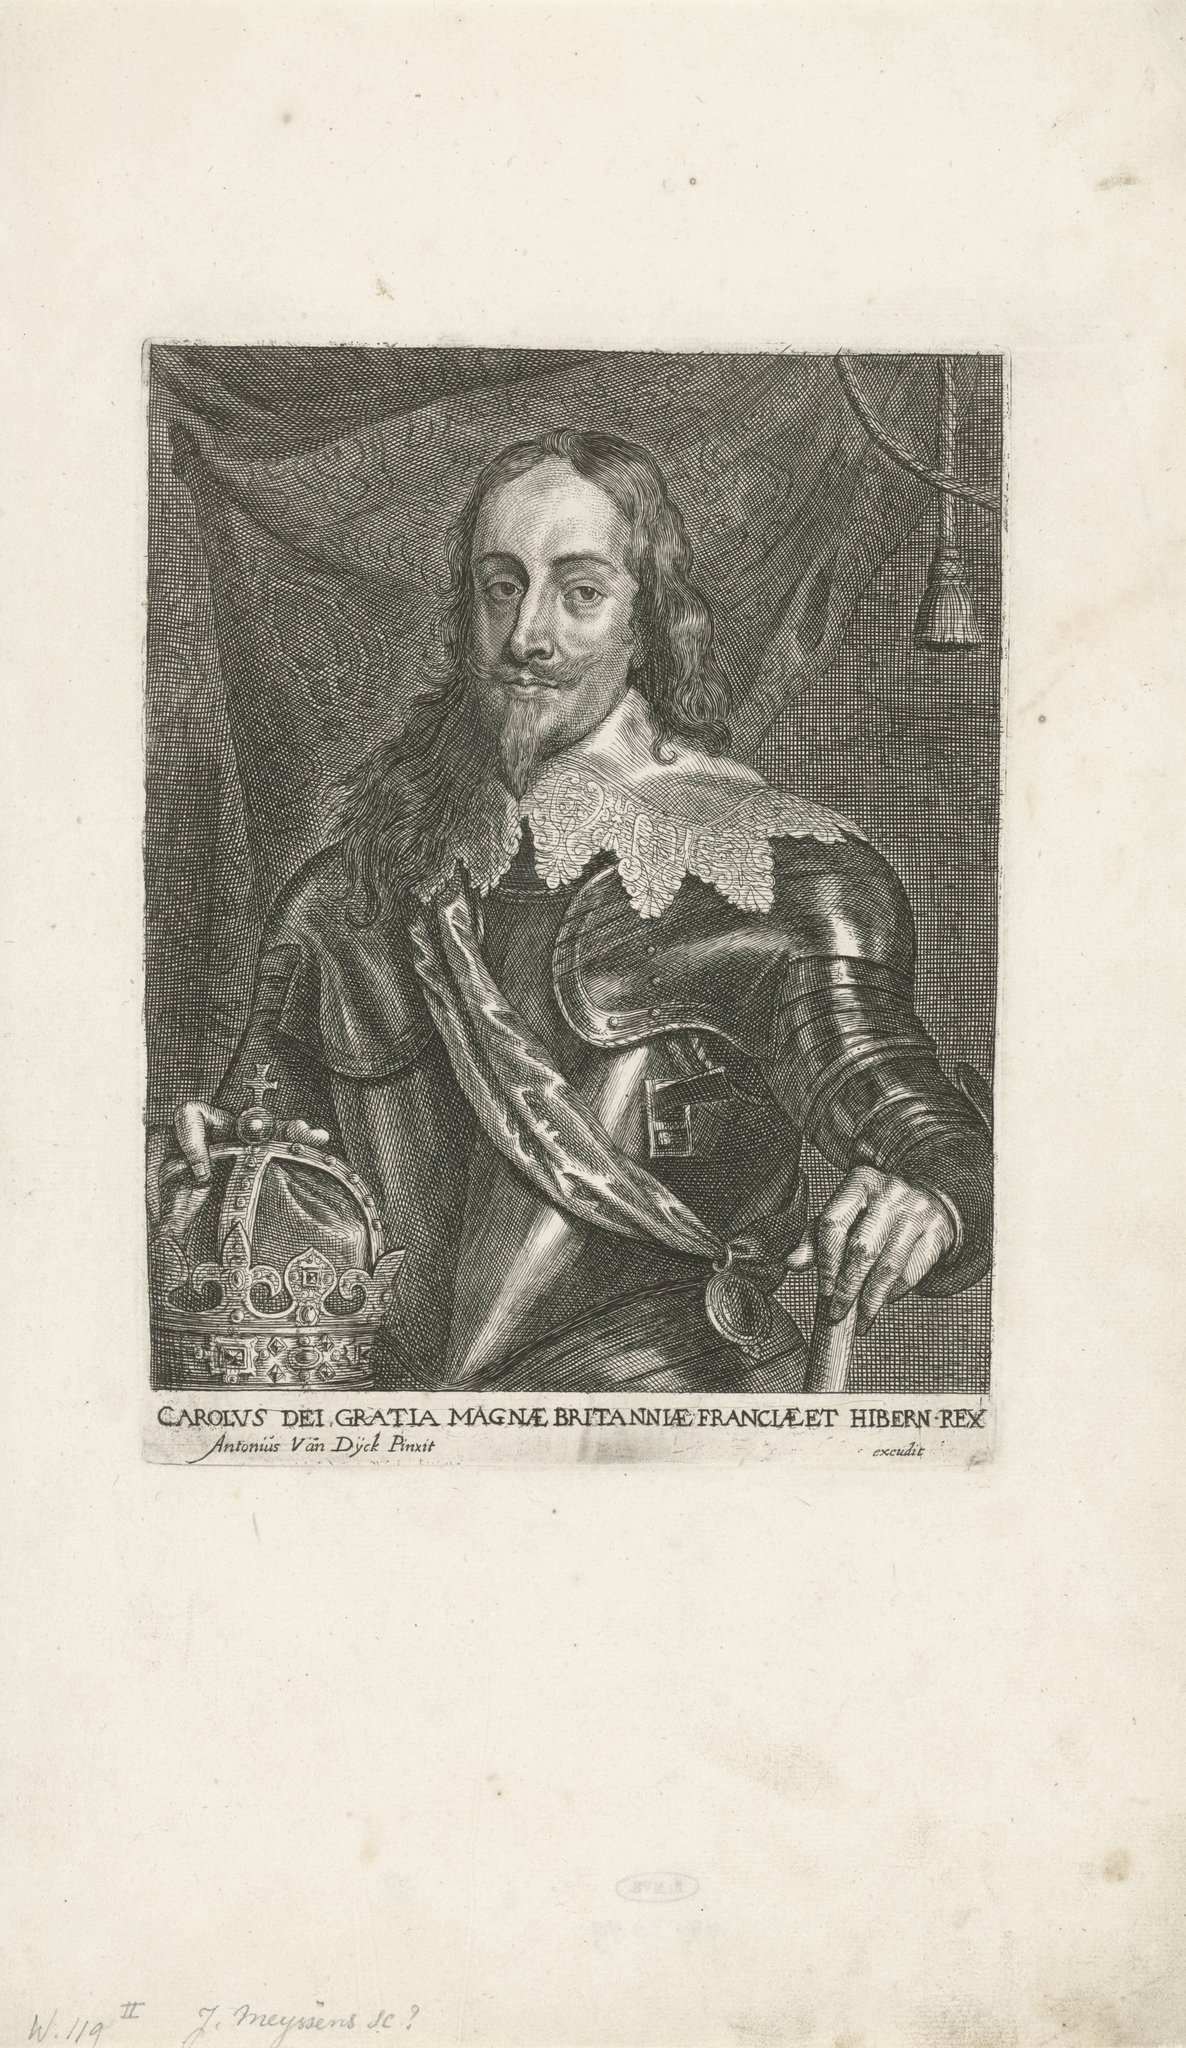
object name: print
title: Portret van koning Karel I van Engeland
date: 1640-1670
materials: paper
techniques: engraving, etching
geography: antwerp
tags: london, karel i (koning van engeland), crown (symbol of sovereignty)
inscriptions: collector's mark: Lugt 2228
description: Portret van Karel I, koning van Engeland. Zijn ene hand rust op zijn kroon, zijn andere hand op een staf.